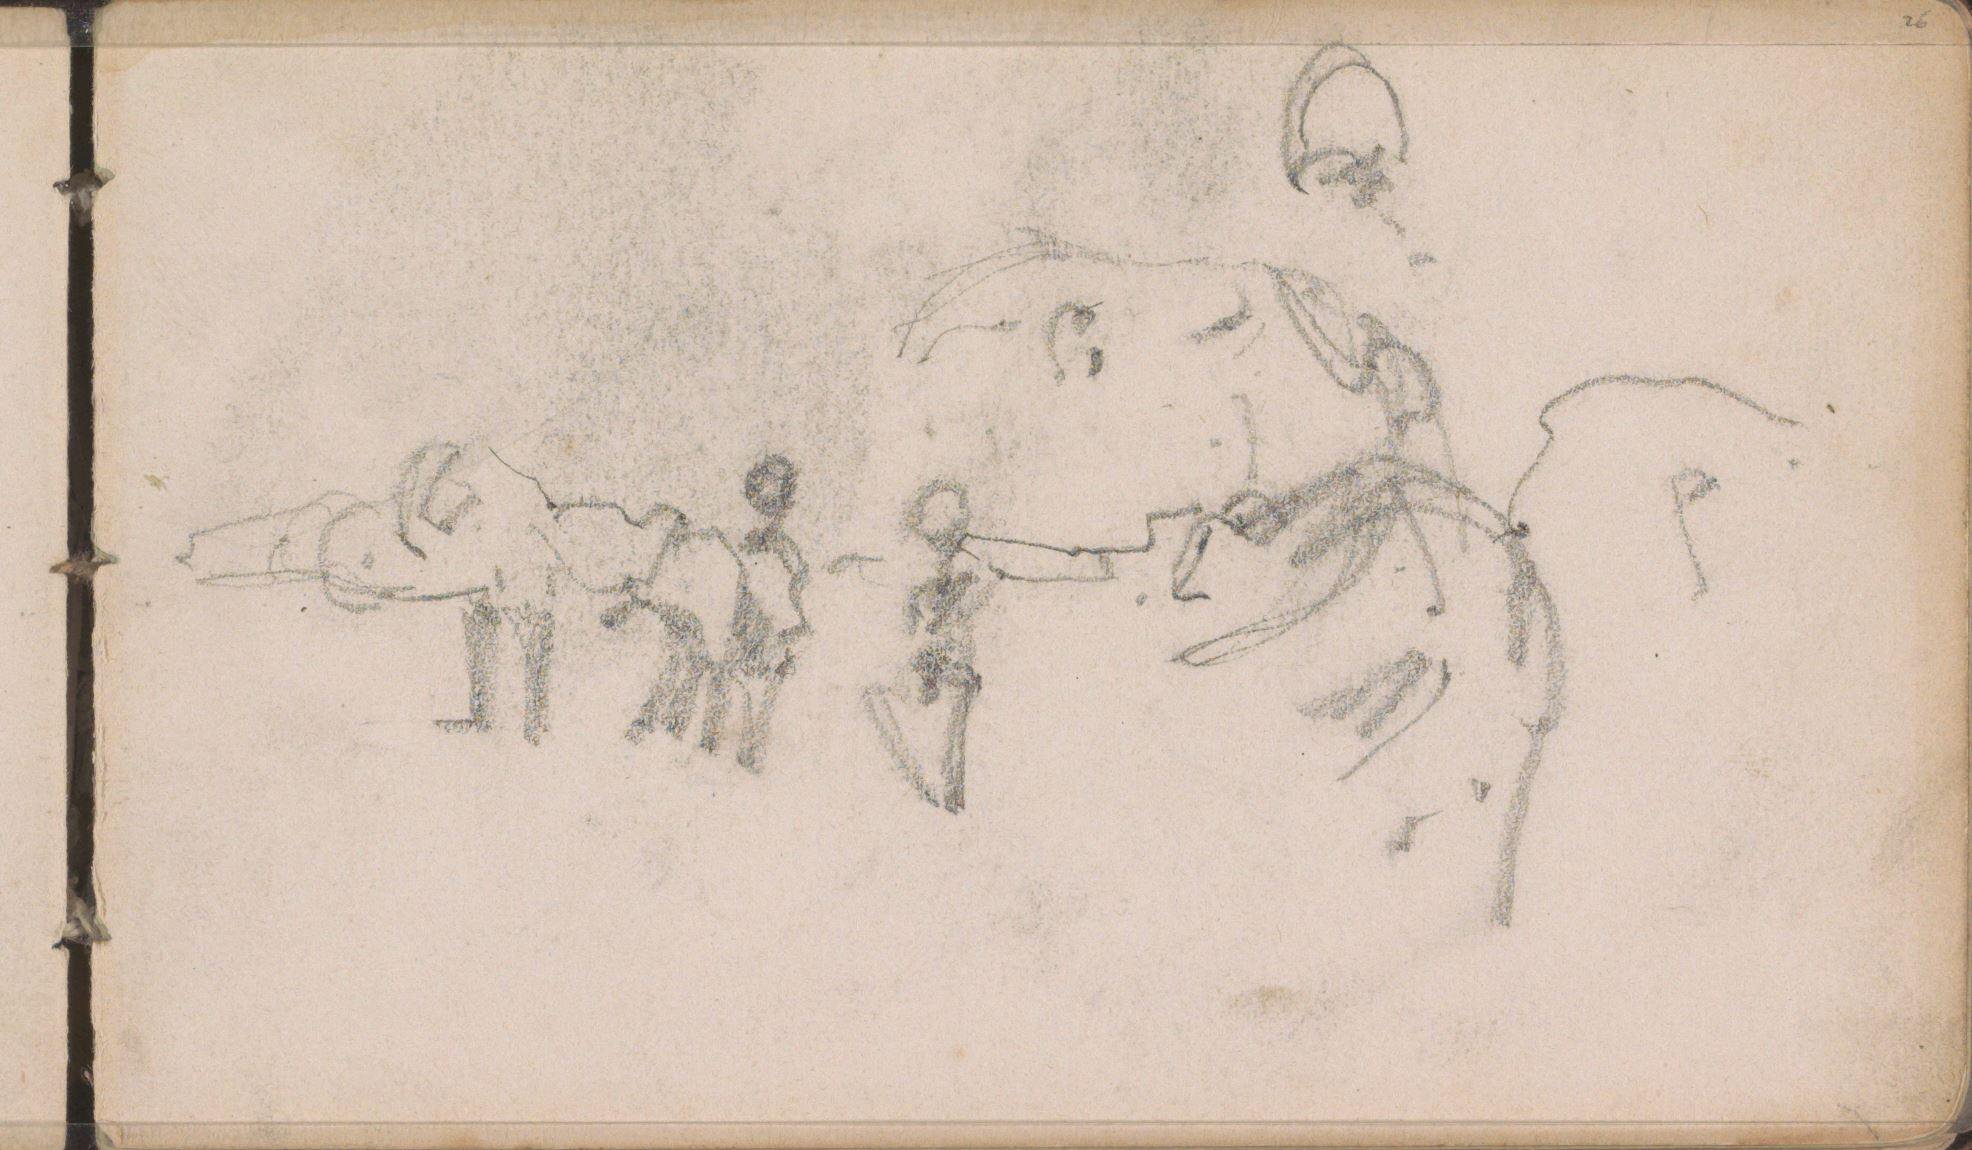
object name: sketchbook leaf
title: Figuurstudies, mogelijk in een landschap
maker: george hendrik breitner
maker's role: draughtsman, painter, print maker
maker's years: 1857-1923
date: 1881-1883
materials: paper, pencil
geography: north brabant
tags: adult woman, landscapes, adult man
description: Pagina 26 uit een schetsboek met 42 bladen.